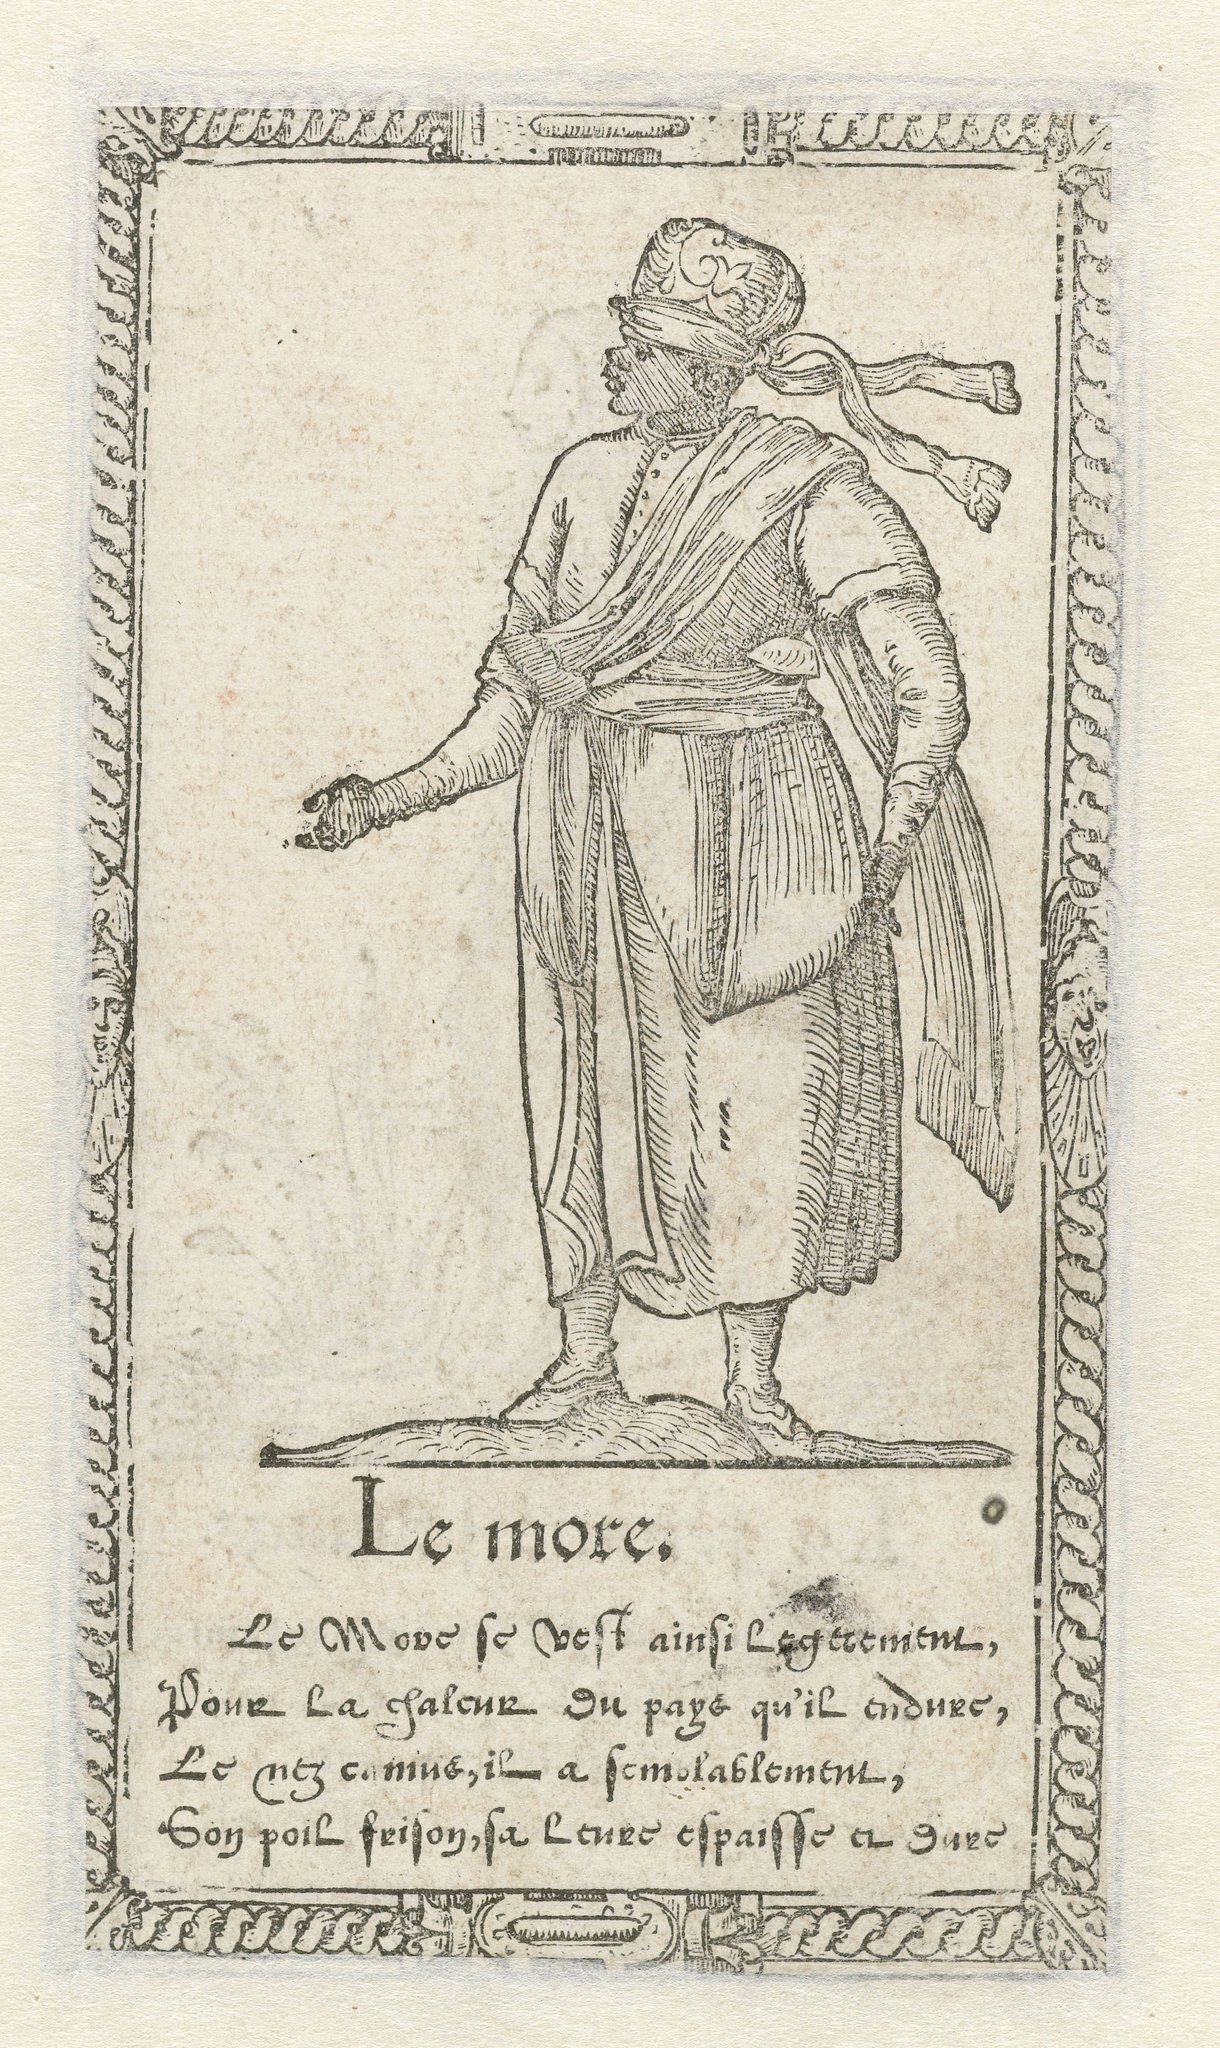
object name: print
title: Man uit Afrika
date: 1562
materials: paper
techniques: woodcut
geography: paris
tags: africans (+ costume), fashion plates, folk costume, regional costume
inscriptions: collector's mark: Lugt 2228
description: Dit is prent 91 uit een serie van 121. Binnen deze serie zijn er prenten gemaakt naar voorbeelden van Jean-François de Roberval en Enea Vico, onbekend welke precies.